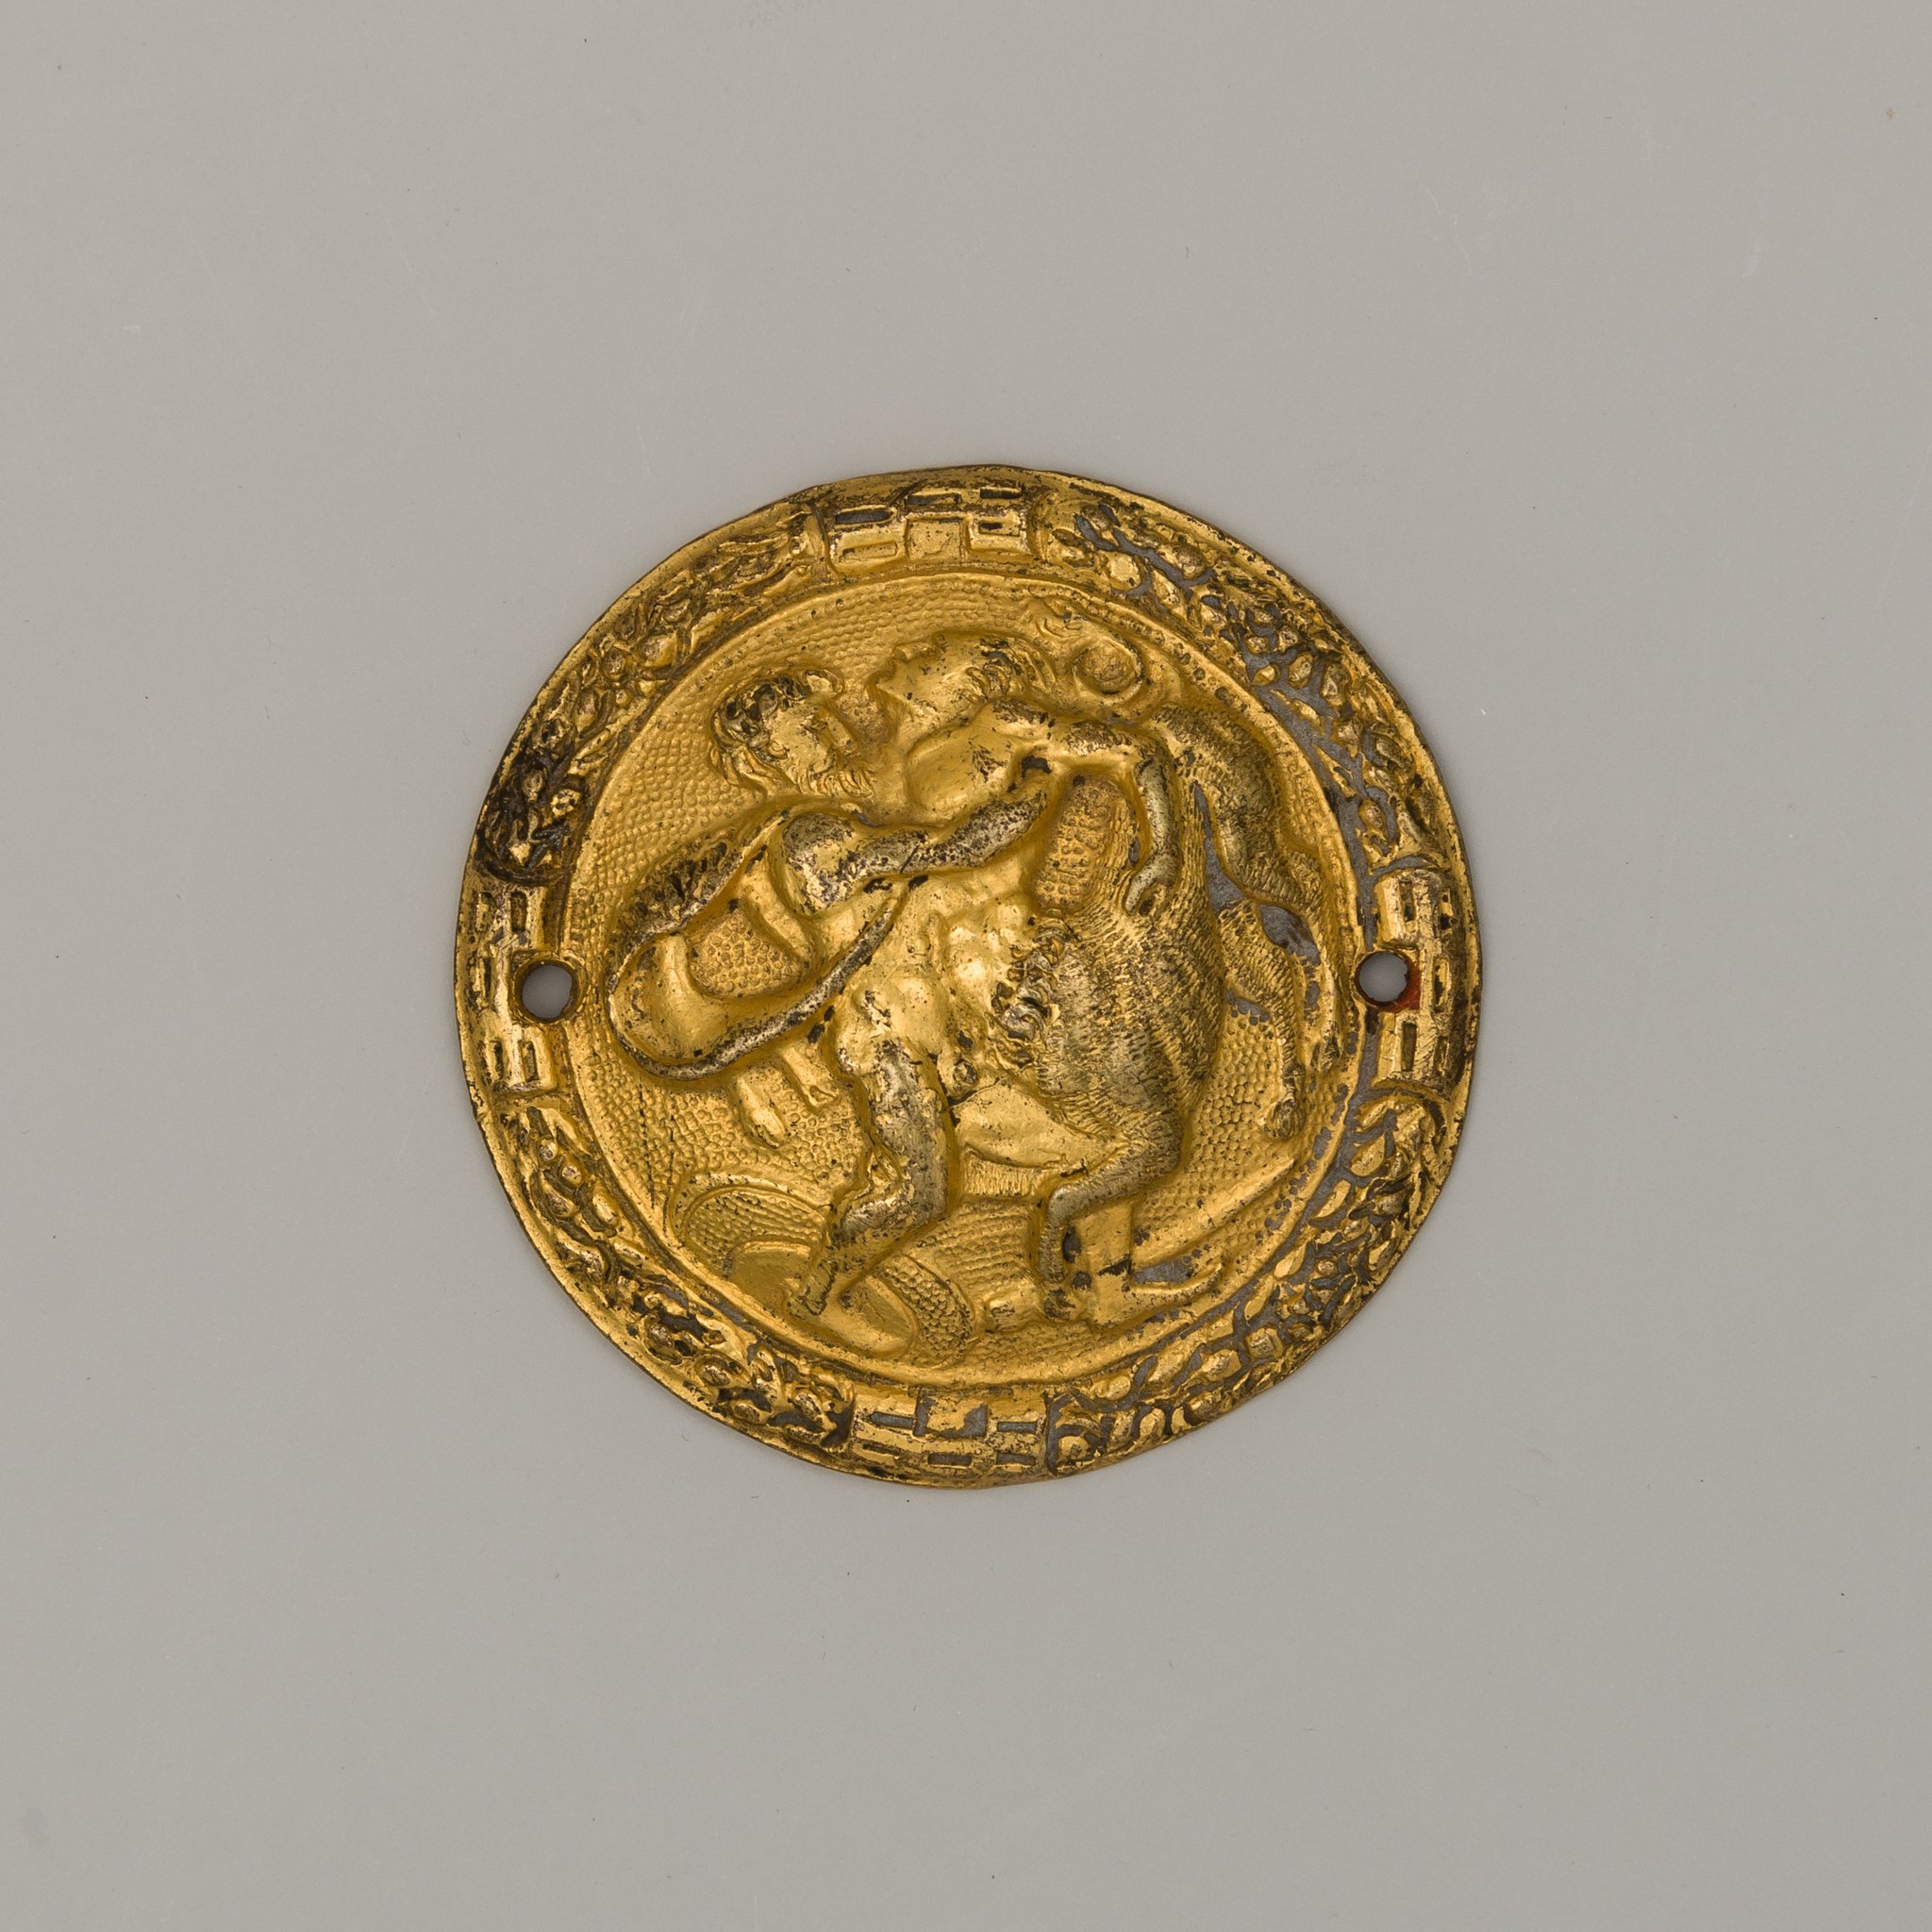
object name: bit bos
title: Bit Boss with Hercules Fighting the Monster Cacus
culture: german, south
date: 1551-1600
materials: copper alloy, gold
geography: germany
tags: hercules,monsters